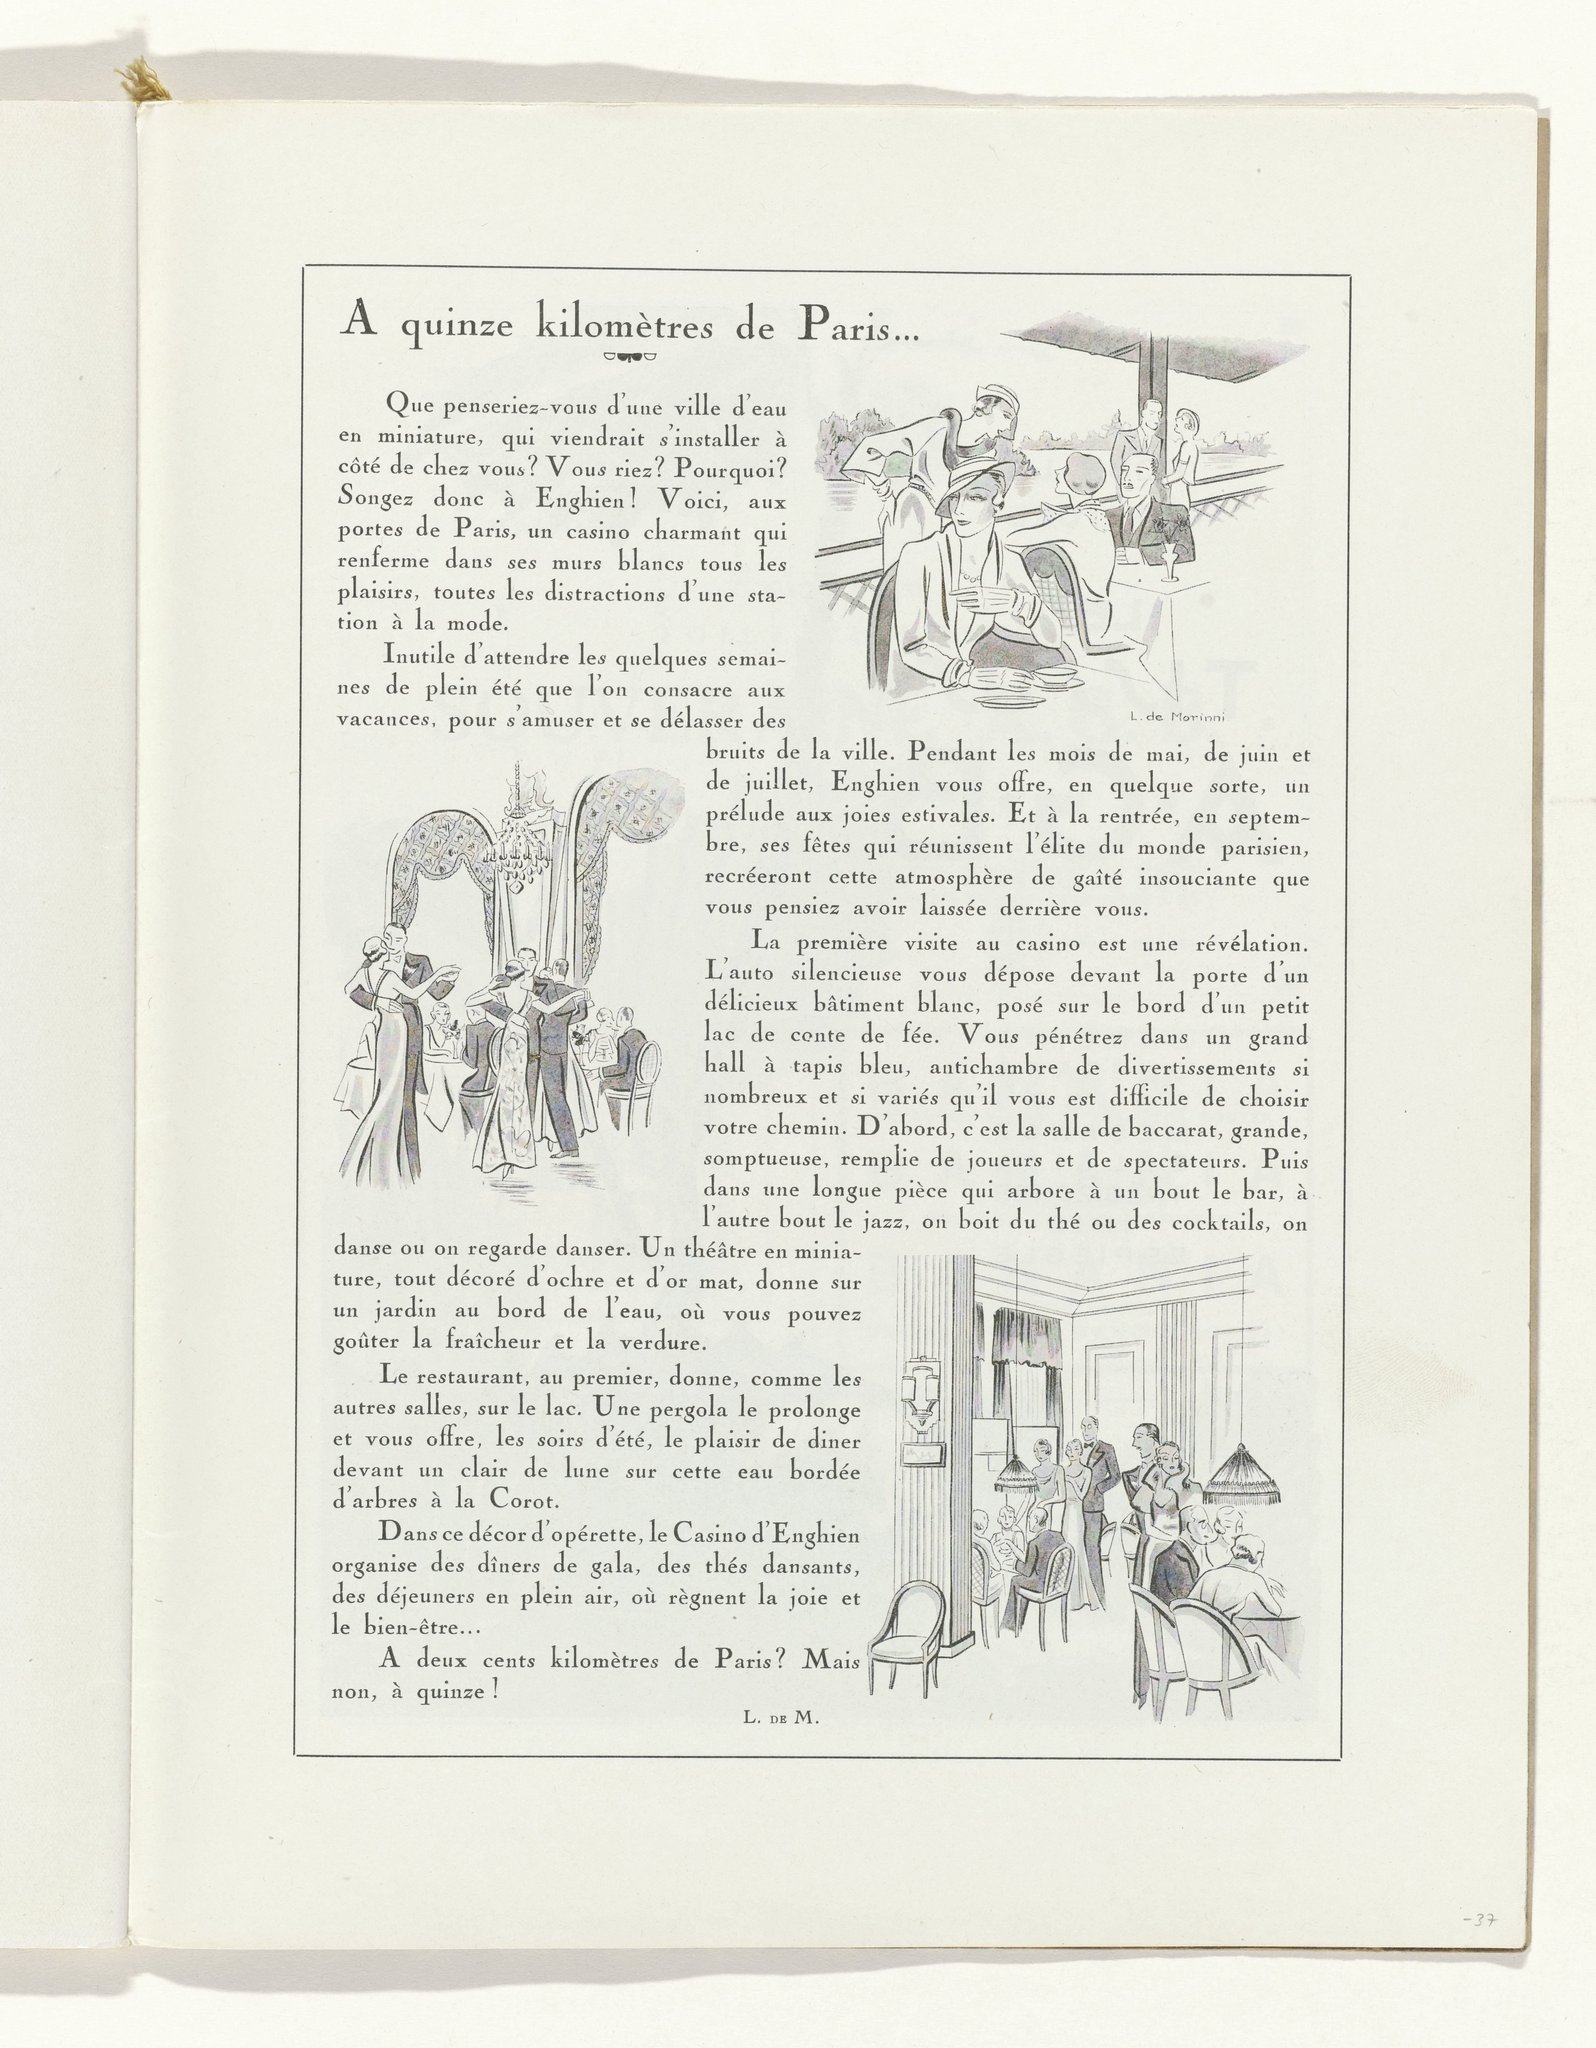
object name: magazine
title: Art - Goût - Beauté, Feuillets de l' élégance féminine, Juin 1932, No. 142, 12e Année, p. 37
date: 1932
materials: paper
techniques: photography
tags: fashion plates, more than one couple dancing, casino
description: Tekst 'A quinze kilomètres de Paris...' met drie afbeeldingen van een elegant gezelschap op een terras, op een dansvloer en in een casino. Pagina uit het modetijdschrift Art-Goût-Beauté (1920-1933).